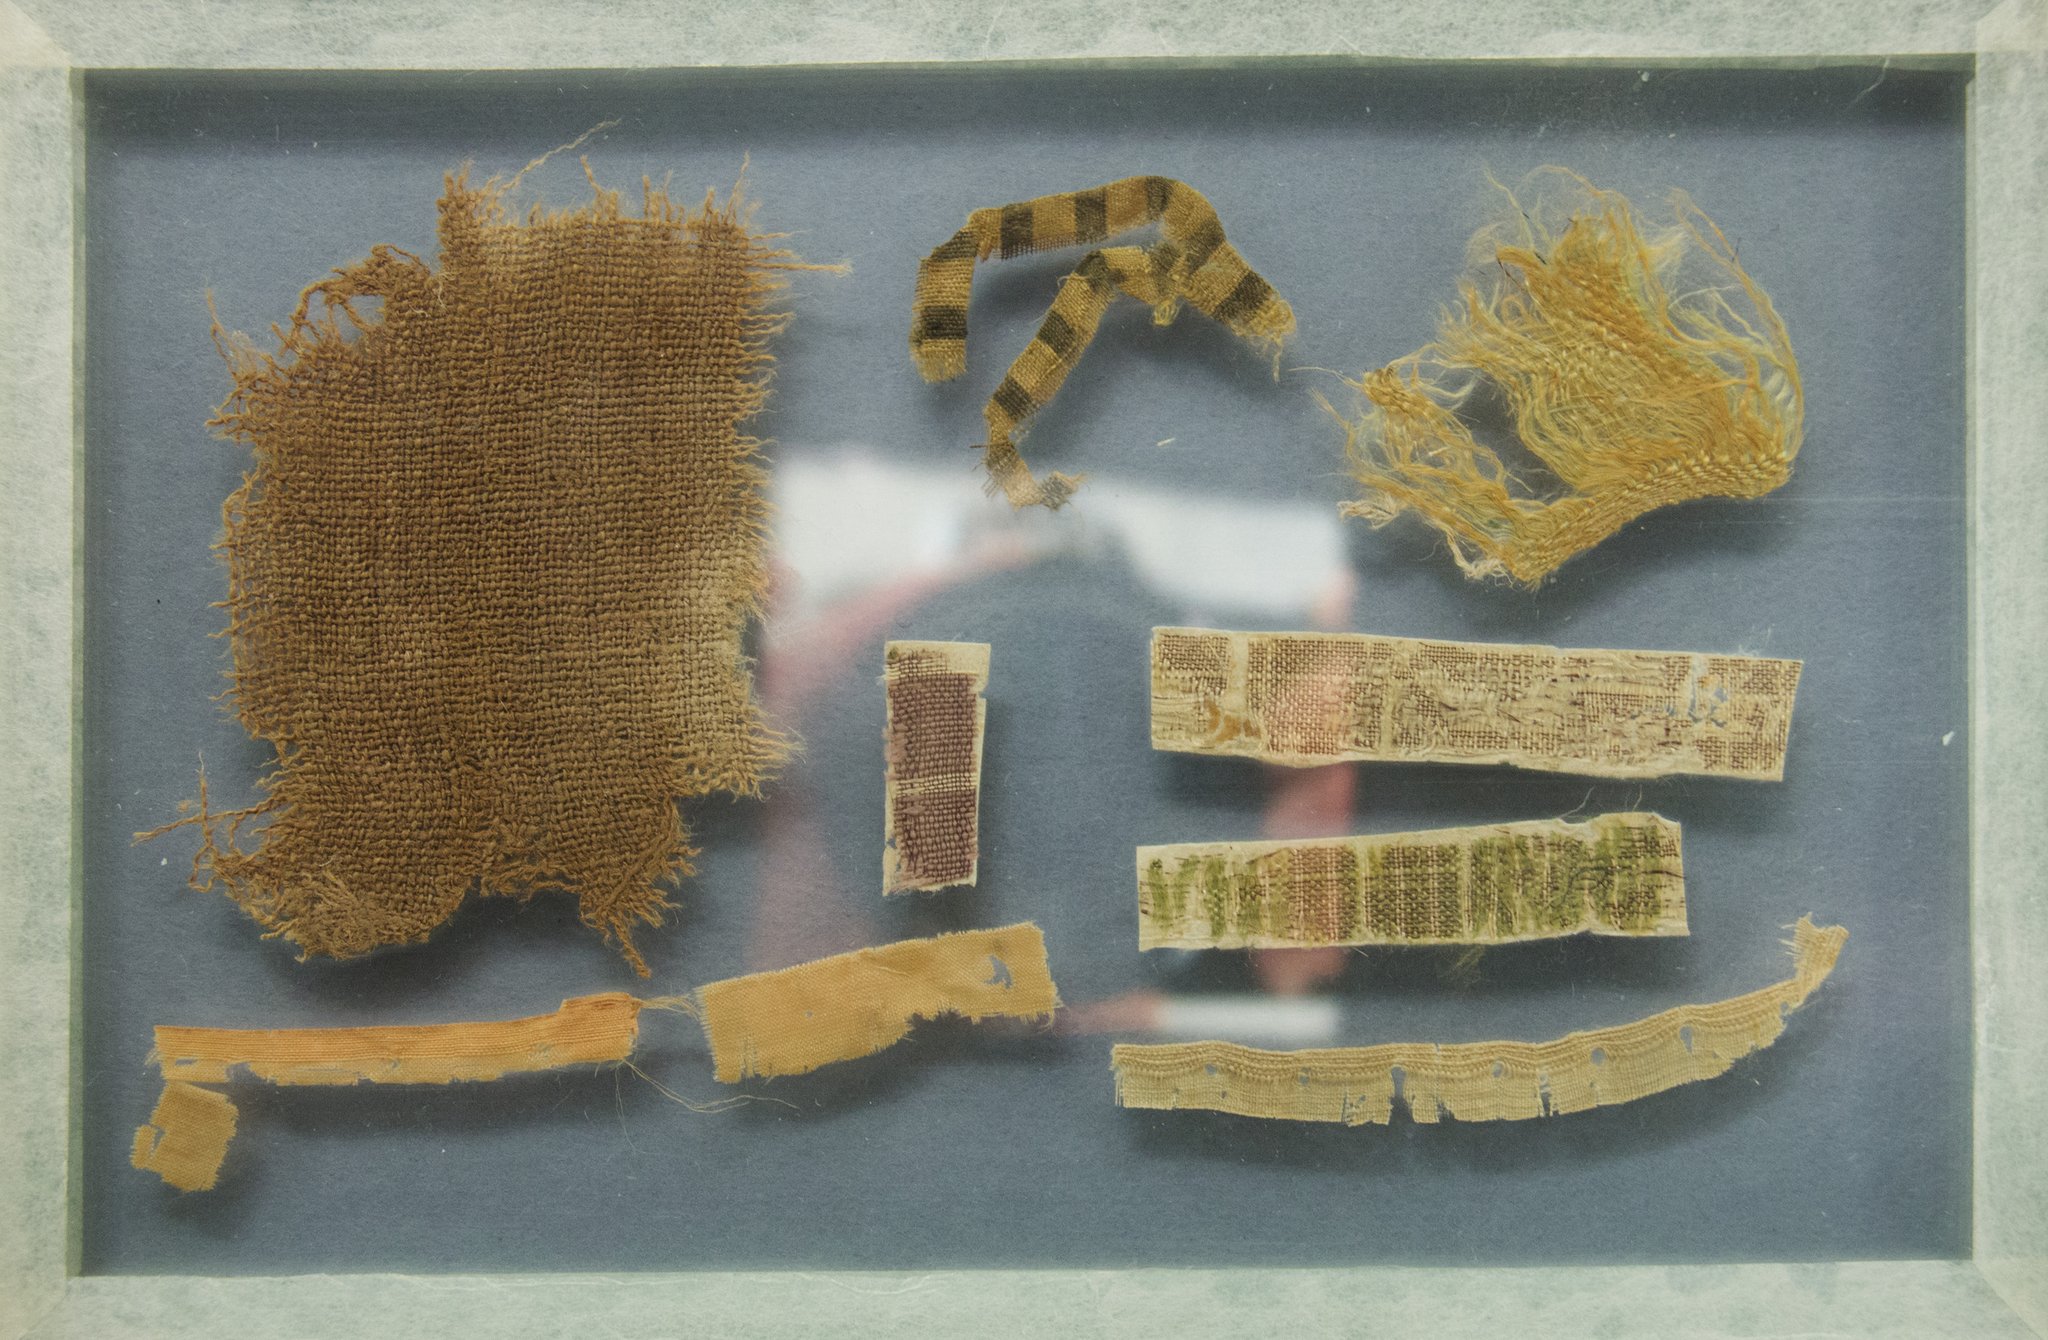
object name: fragment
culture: japanese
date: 701-800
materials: textile, cotton, linen, silk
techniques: weave